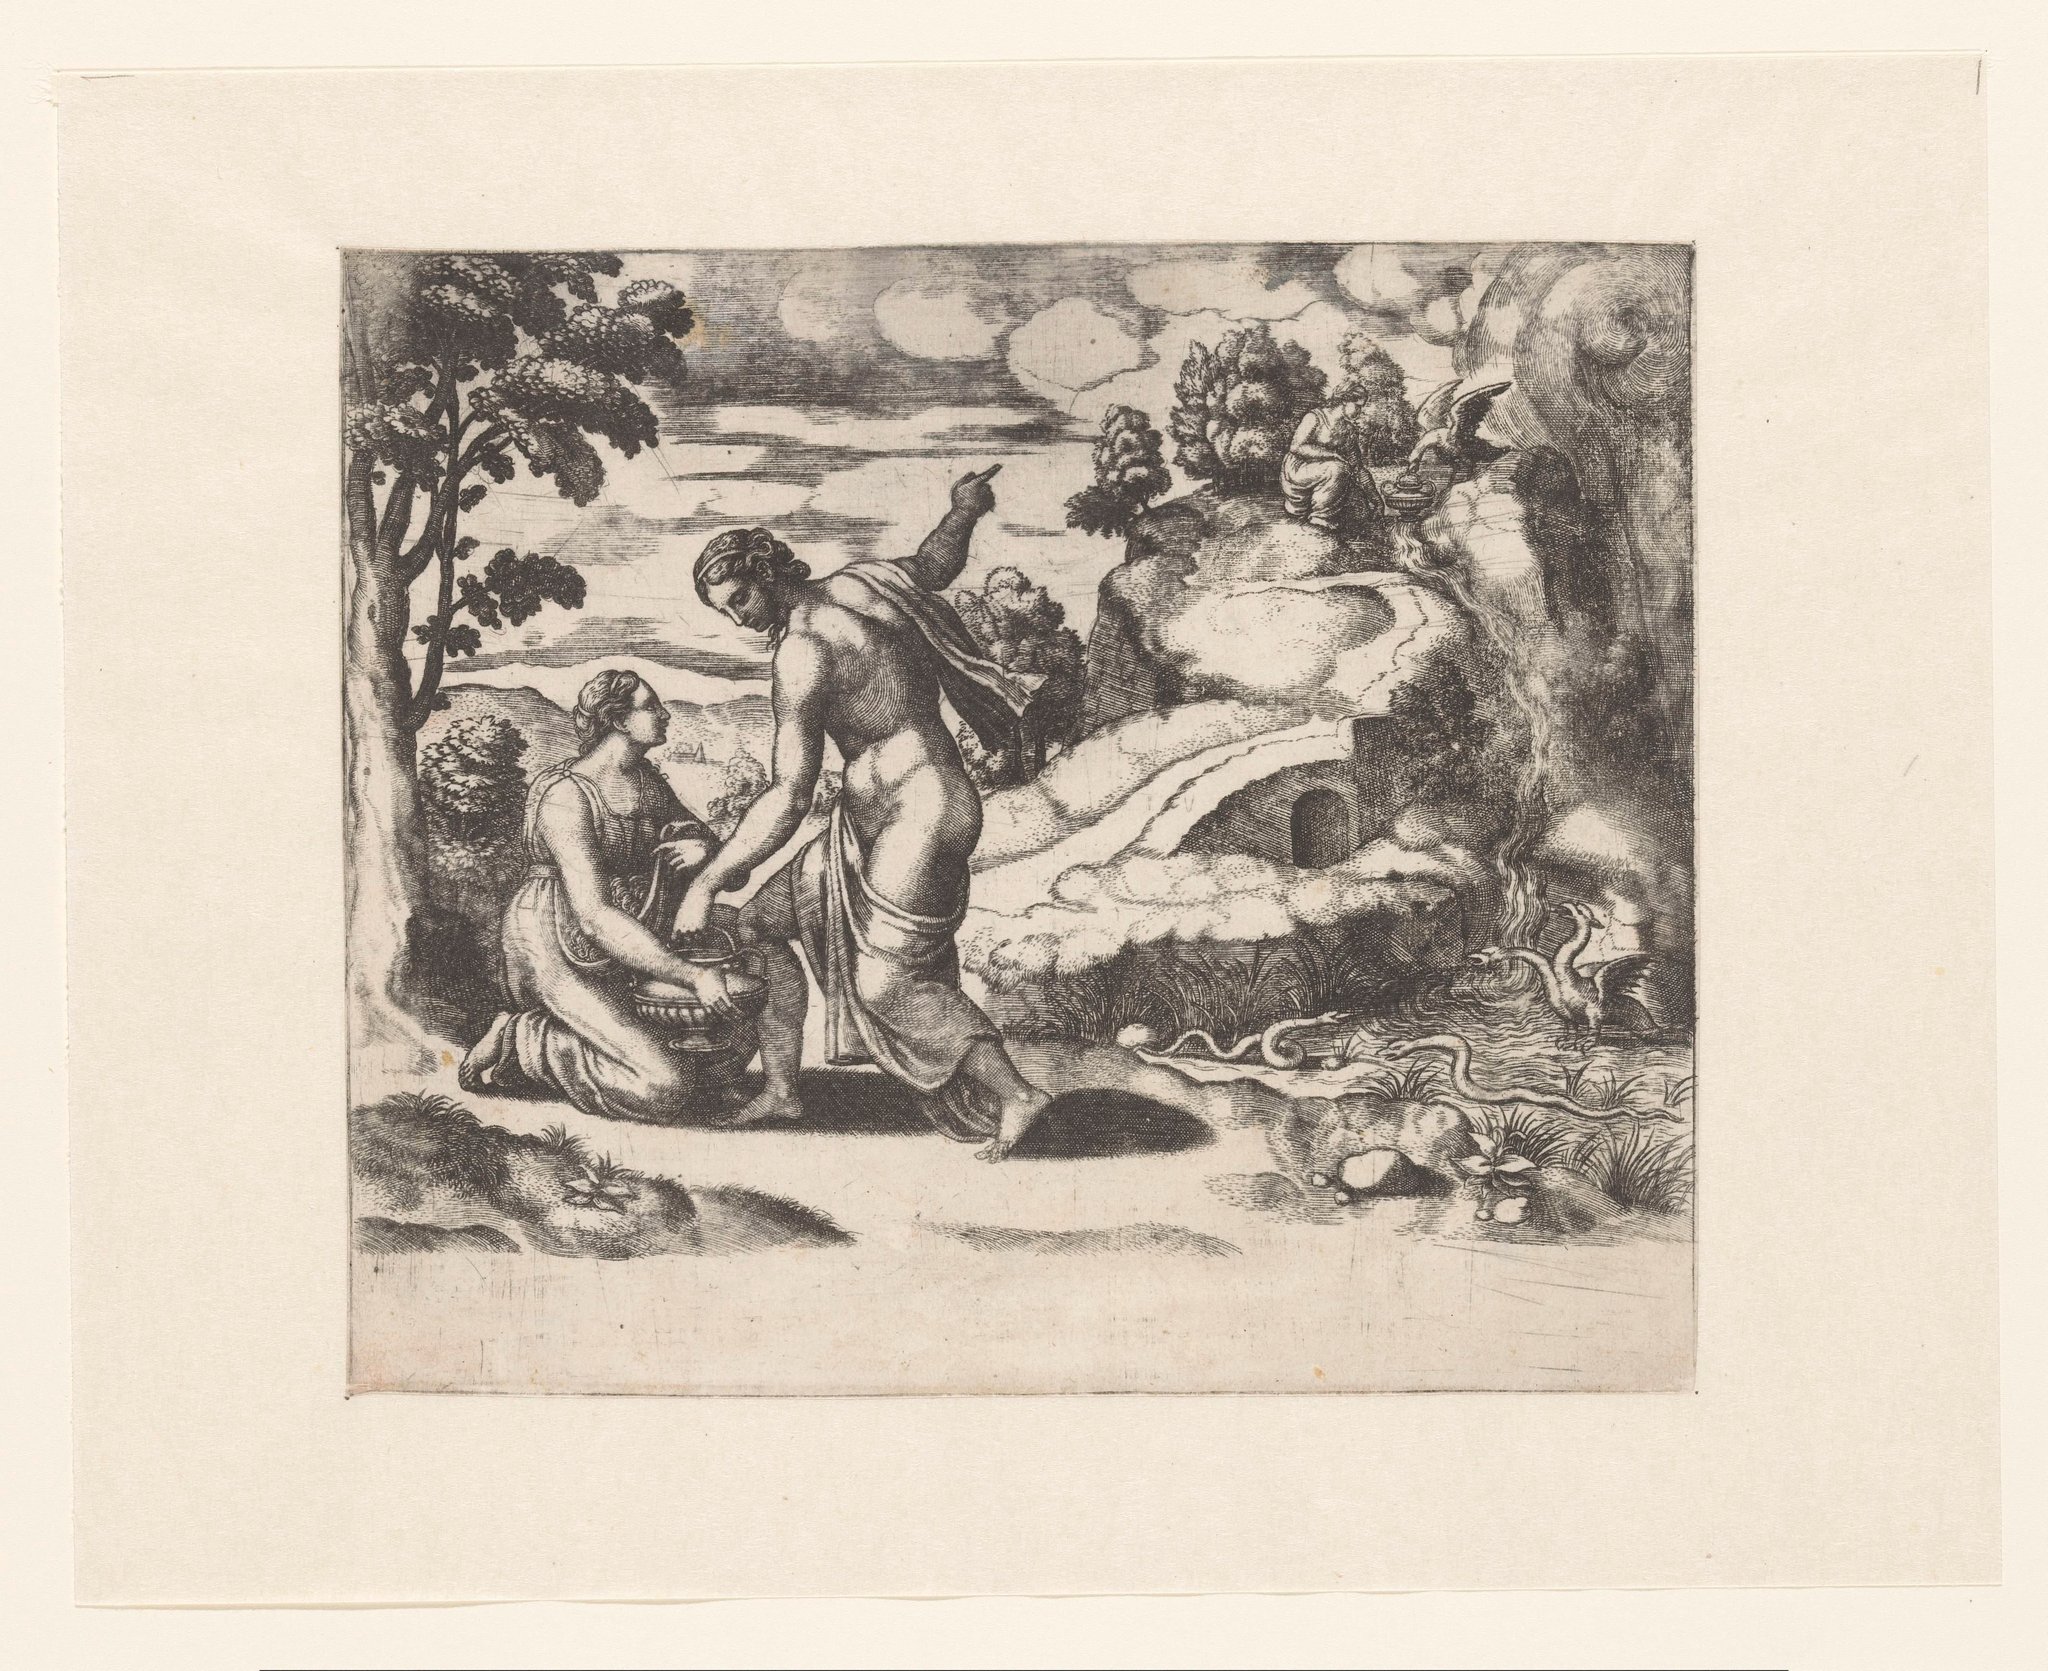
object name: print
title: Venus stuurt Psyche naar een bron bewaakt door draken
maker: meester van de dobbelsteen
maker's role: print maker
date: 1530-1560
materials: paper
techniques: engraving, intaglio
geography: italy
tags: the eagle of jupiter fetches water from the styx with psyche's jar, psyche performing various tasks set to her by venus, styx (river of hades); 'stige' (ripa)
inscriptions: collector's mark: Lugt 2228, collector's mark: Lugt 2760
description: Venus draagt Psyche de taak op om water te halen uit een bron die bewaakt wordt door draken. Rechts op een berg de adelaar van Jupiter die Psyche water brengt uit de Styx.